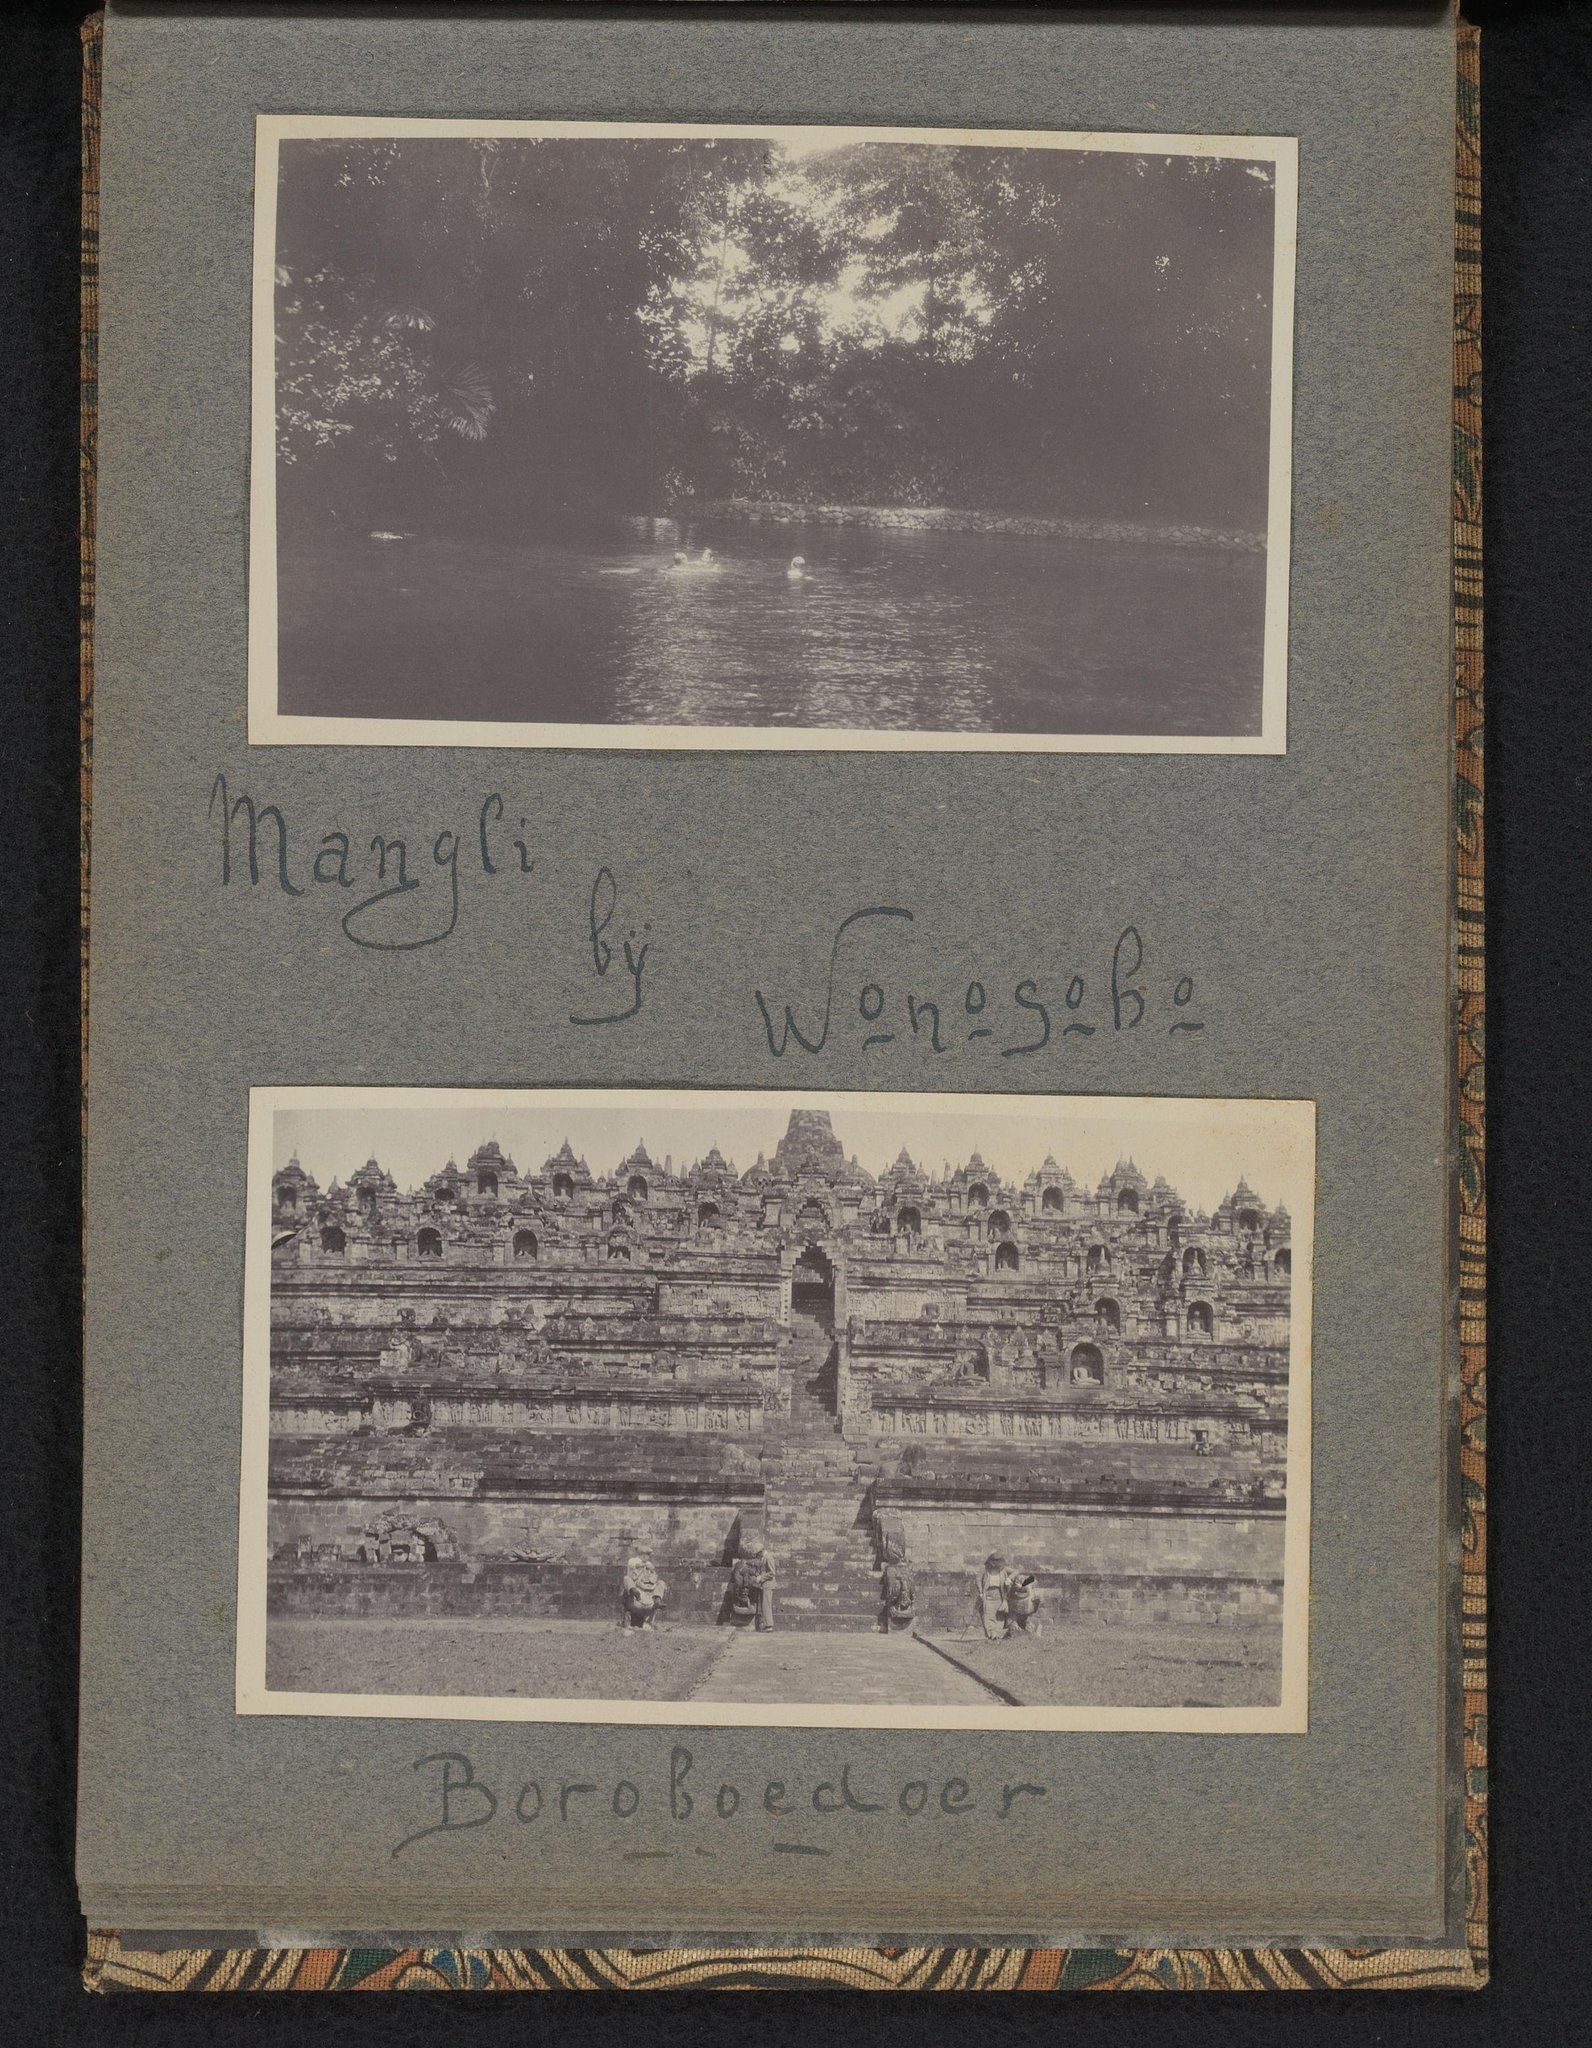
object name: photograph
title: Arendina van den Berg met haar twee zoons in een meer bij Mangli, Wonosobo in Midden-Java, en een gezicht op de Borobudur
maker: karel frederik van den berg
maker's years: 1873-1948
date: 1921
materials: paper, cardboard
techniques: gelatin silver print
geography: central java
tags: norbert van den berg (1901-1972), amsterdam, willem jacob van den berg, arendina charlotte marie van den berg-geertsema, temple, shrine ~ hinduism, buddhism, jainism, swimming (movement in water)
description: Deze foto's zijn onderdeel van een album.